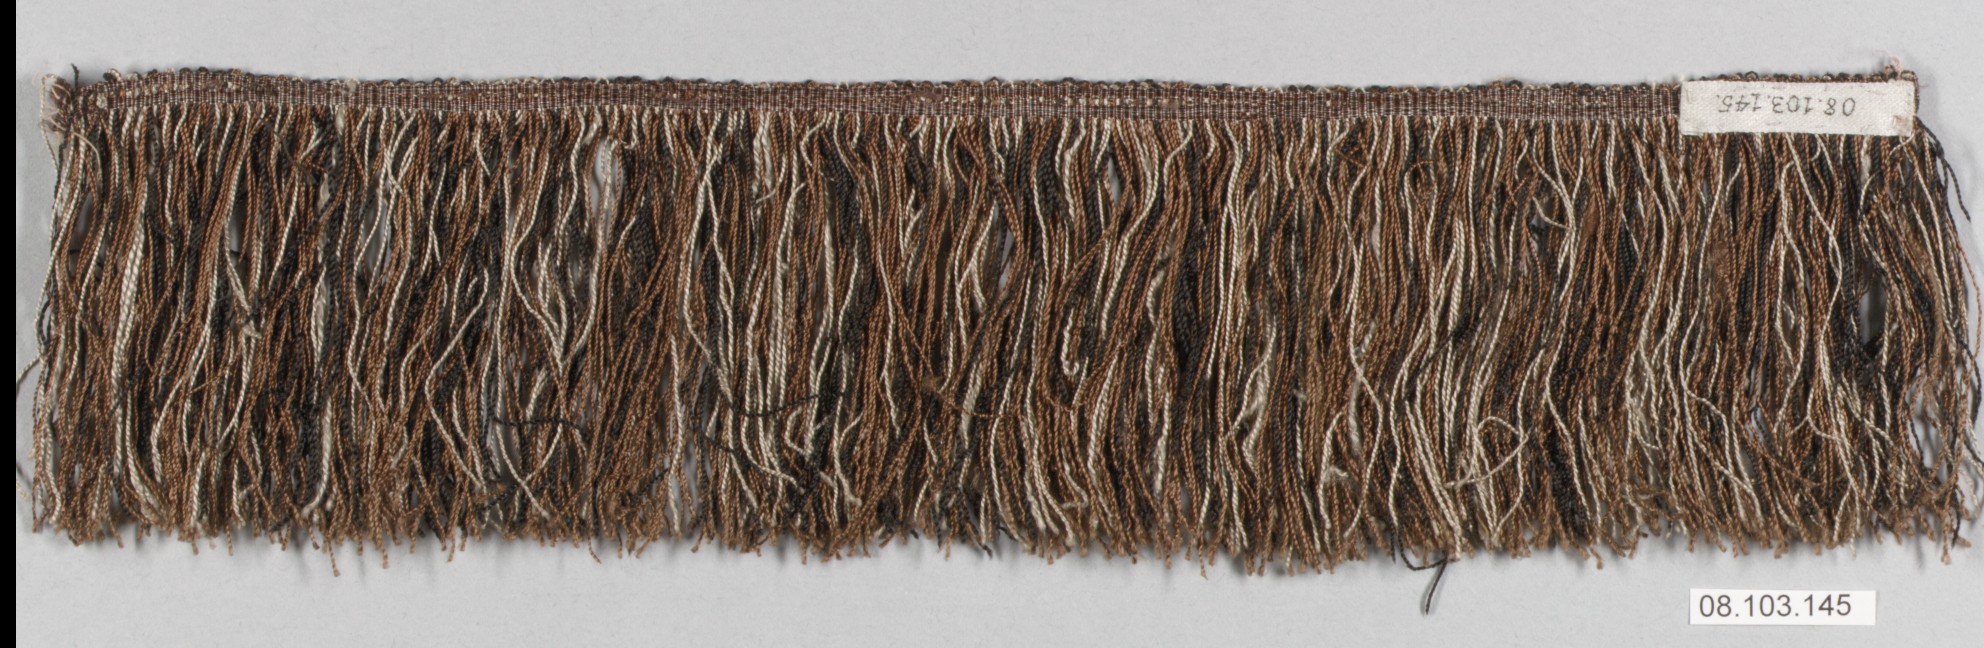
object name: fringe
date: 1801-1900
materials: silk